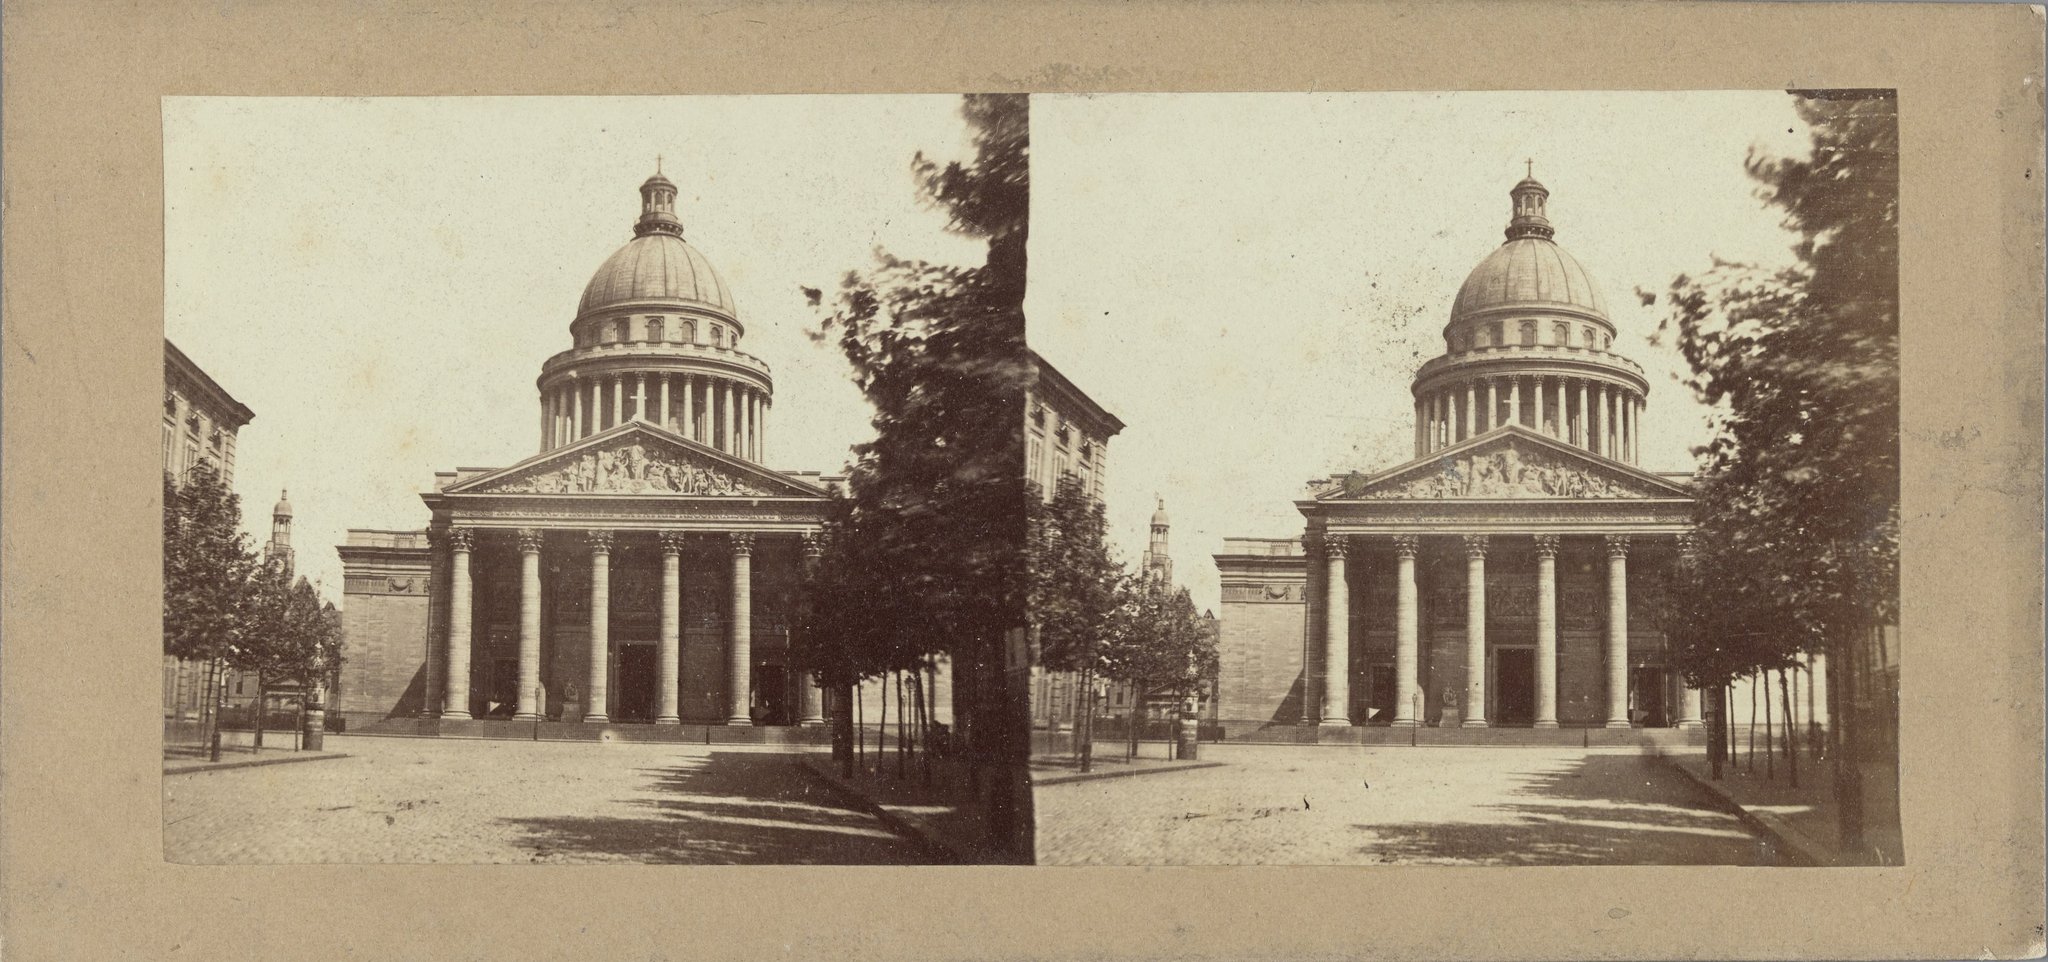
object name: stereograph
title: Panthéon in Parijs gezien vanaf de Rue Soufflot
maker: Anonymous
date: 1860-1880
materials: cardboard, paper, photographic support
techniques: albumen print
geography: paris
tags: façade (of house or building), dome ~ architecture, paris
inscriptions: inscription: ‘Banselin opticien [...] 14. R. de Seine Paris’